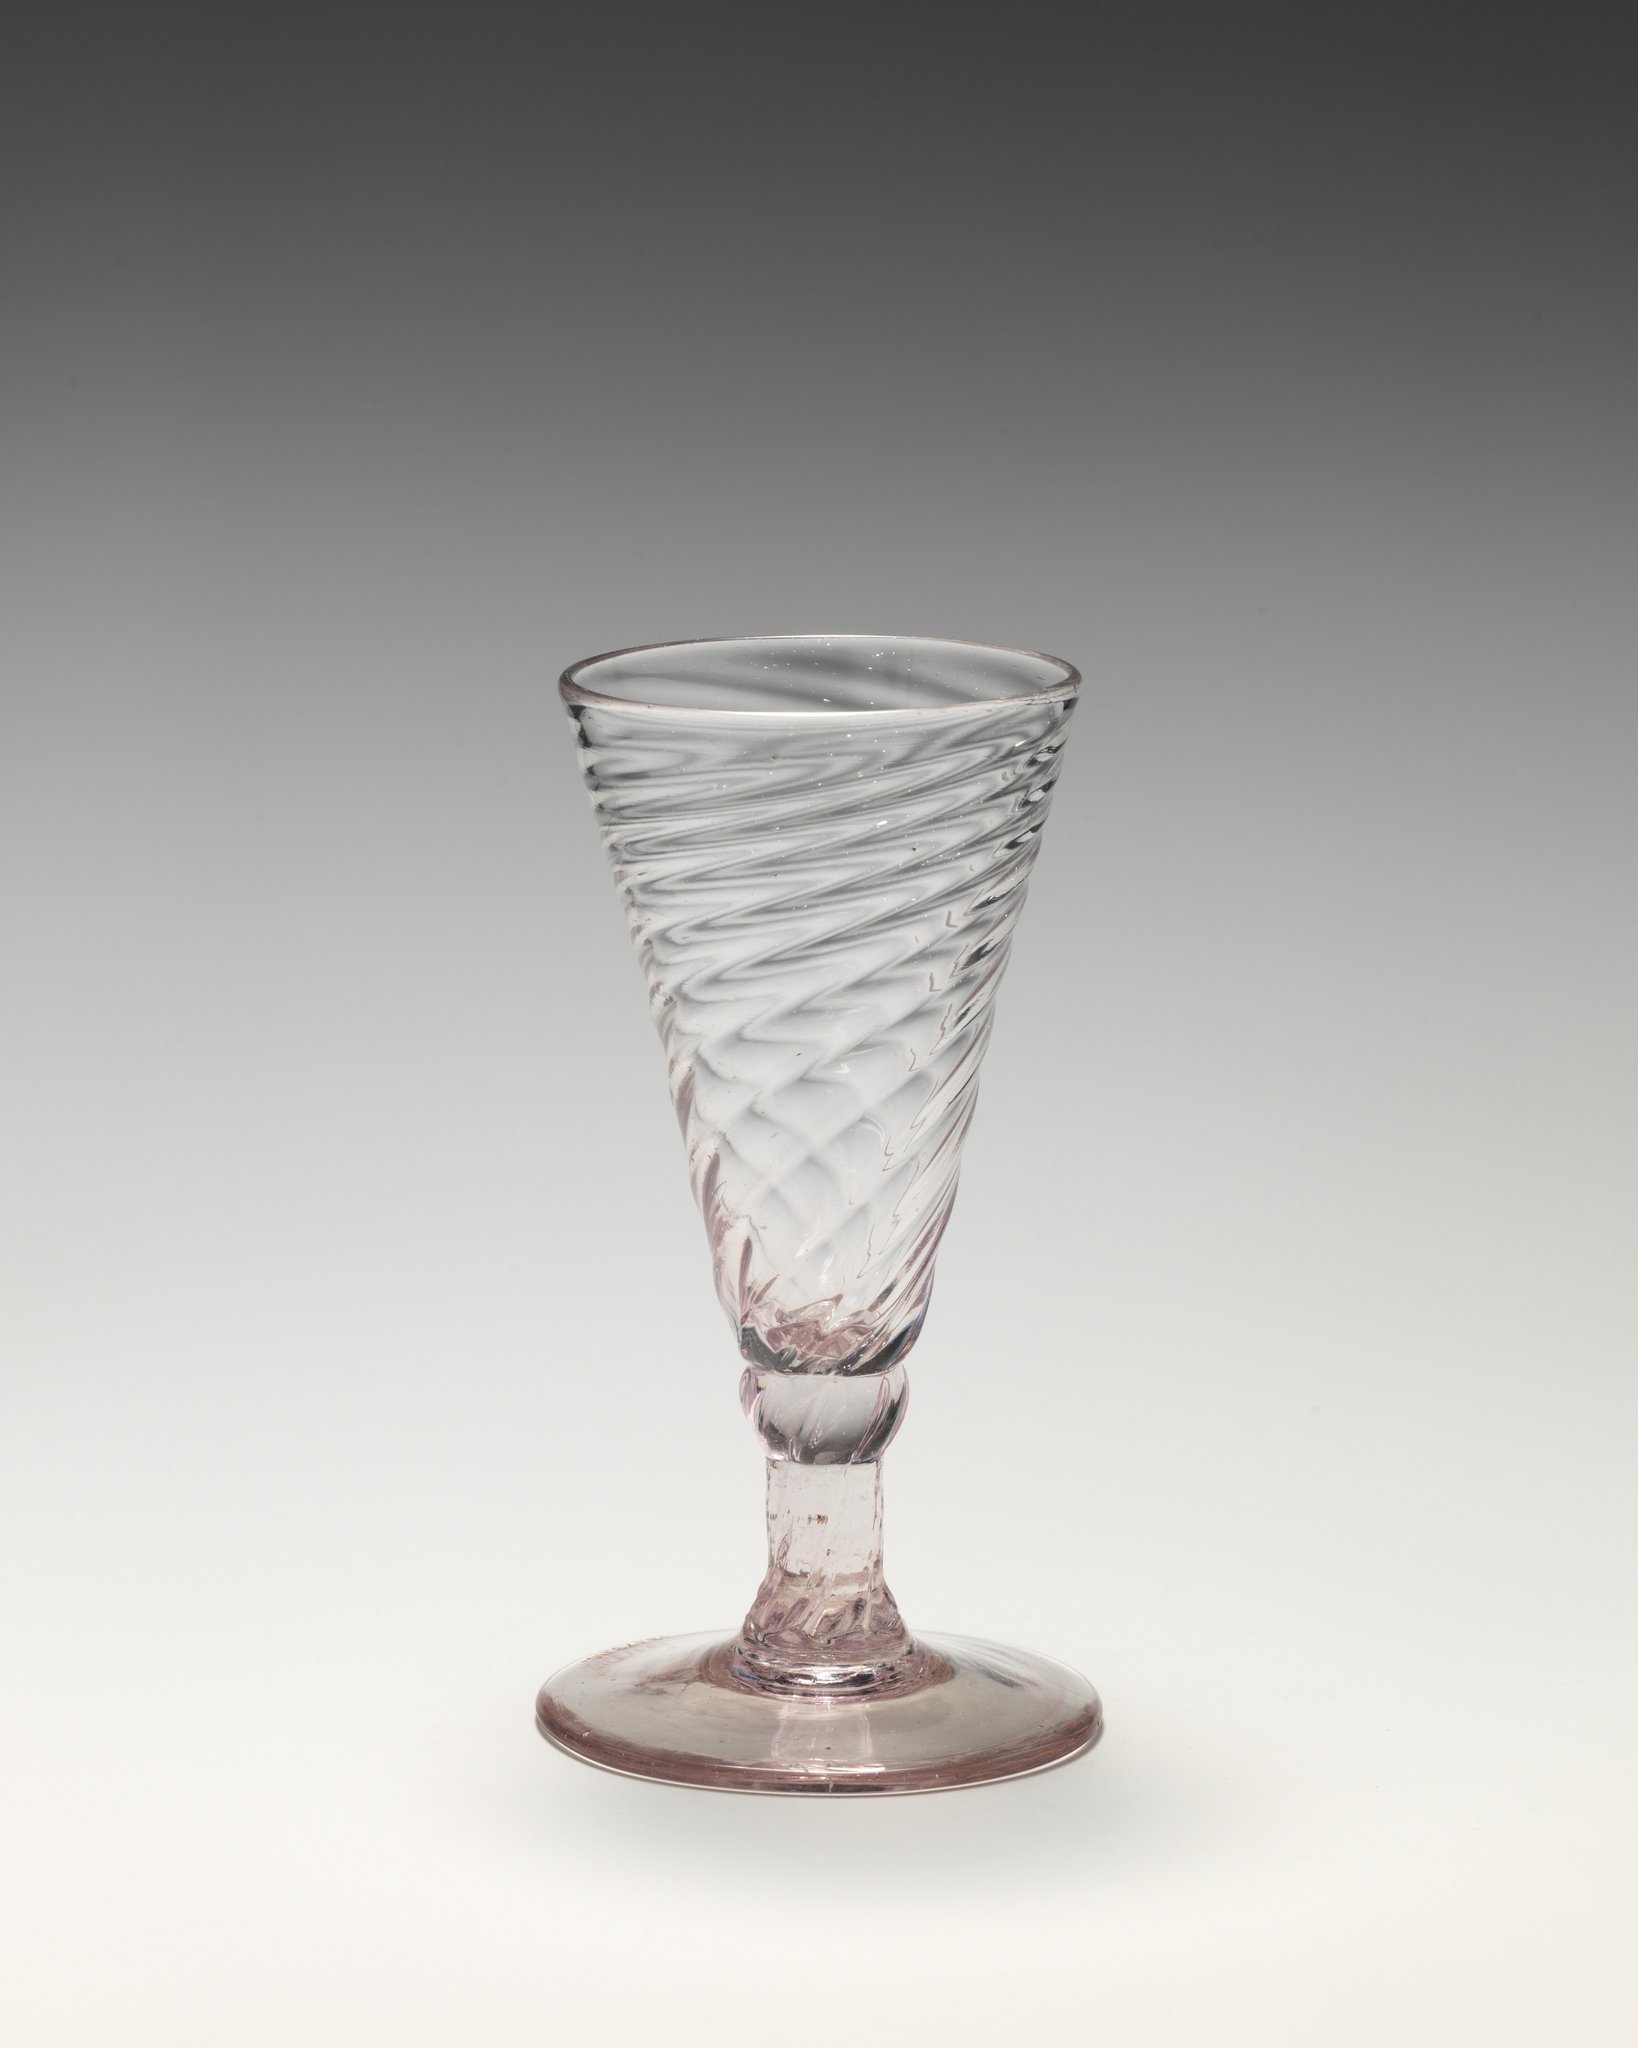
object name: ale glass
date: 1734-1766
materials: glass